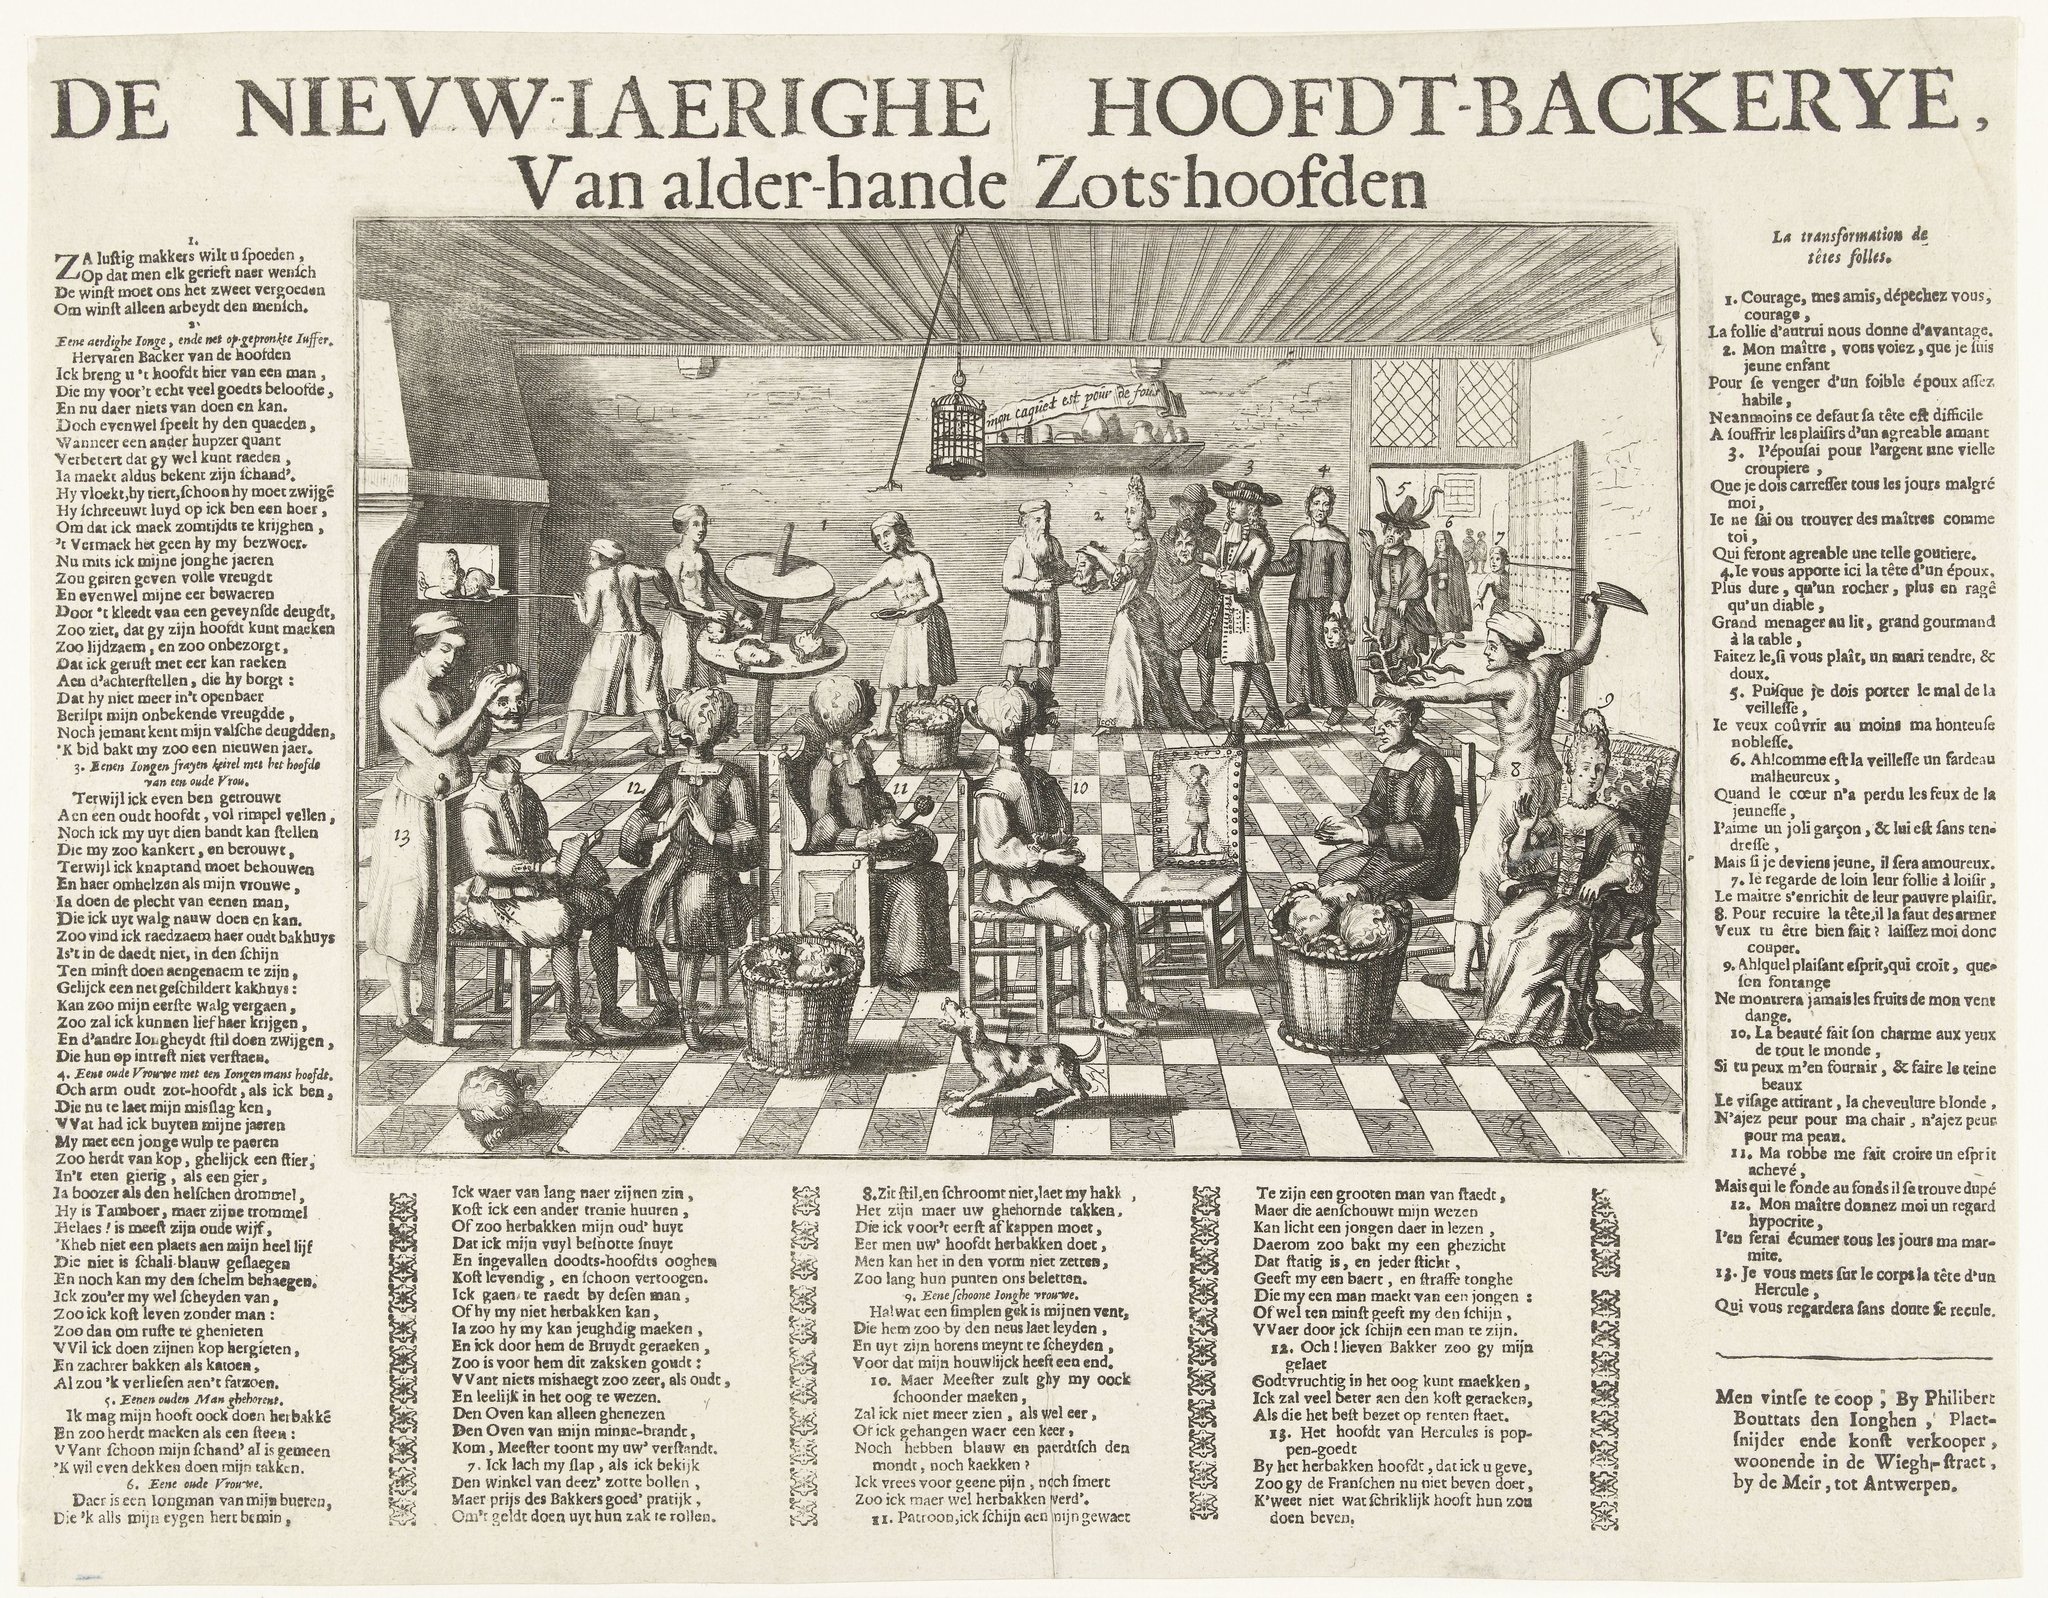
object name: cartoon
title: De Nieuw-jaerighe Hoofdt-backerye, Van alder-hande Zots-hoofden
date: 1690-1710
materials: paper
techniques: etching, letterpress printing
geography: southern netherlands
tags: baking the head, e.g. by the baker of eeclo (heads temporarily replaced by cabbages)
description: De legende van de bakker van Eekloo. Interieur van een keuken waar mensen hun hoofden in een oven laten ombakken, in de tussentijd wordt zolang een groene kool op de hals gezet. In het onderschrift verzen genummerd 1-13 in het Nederlands en Frans.